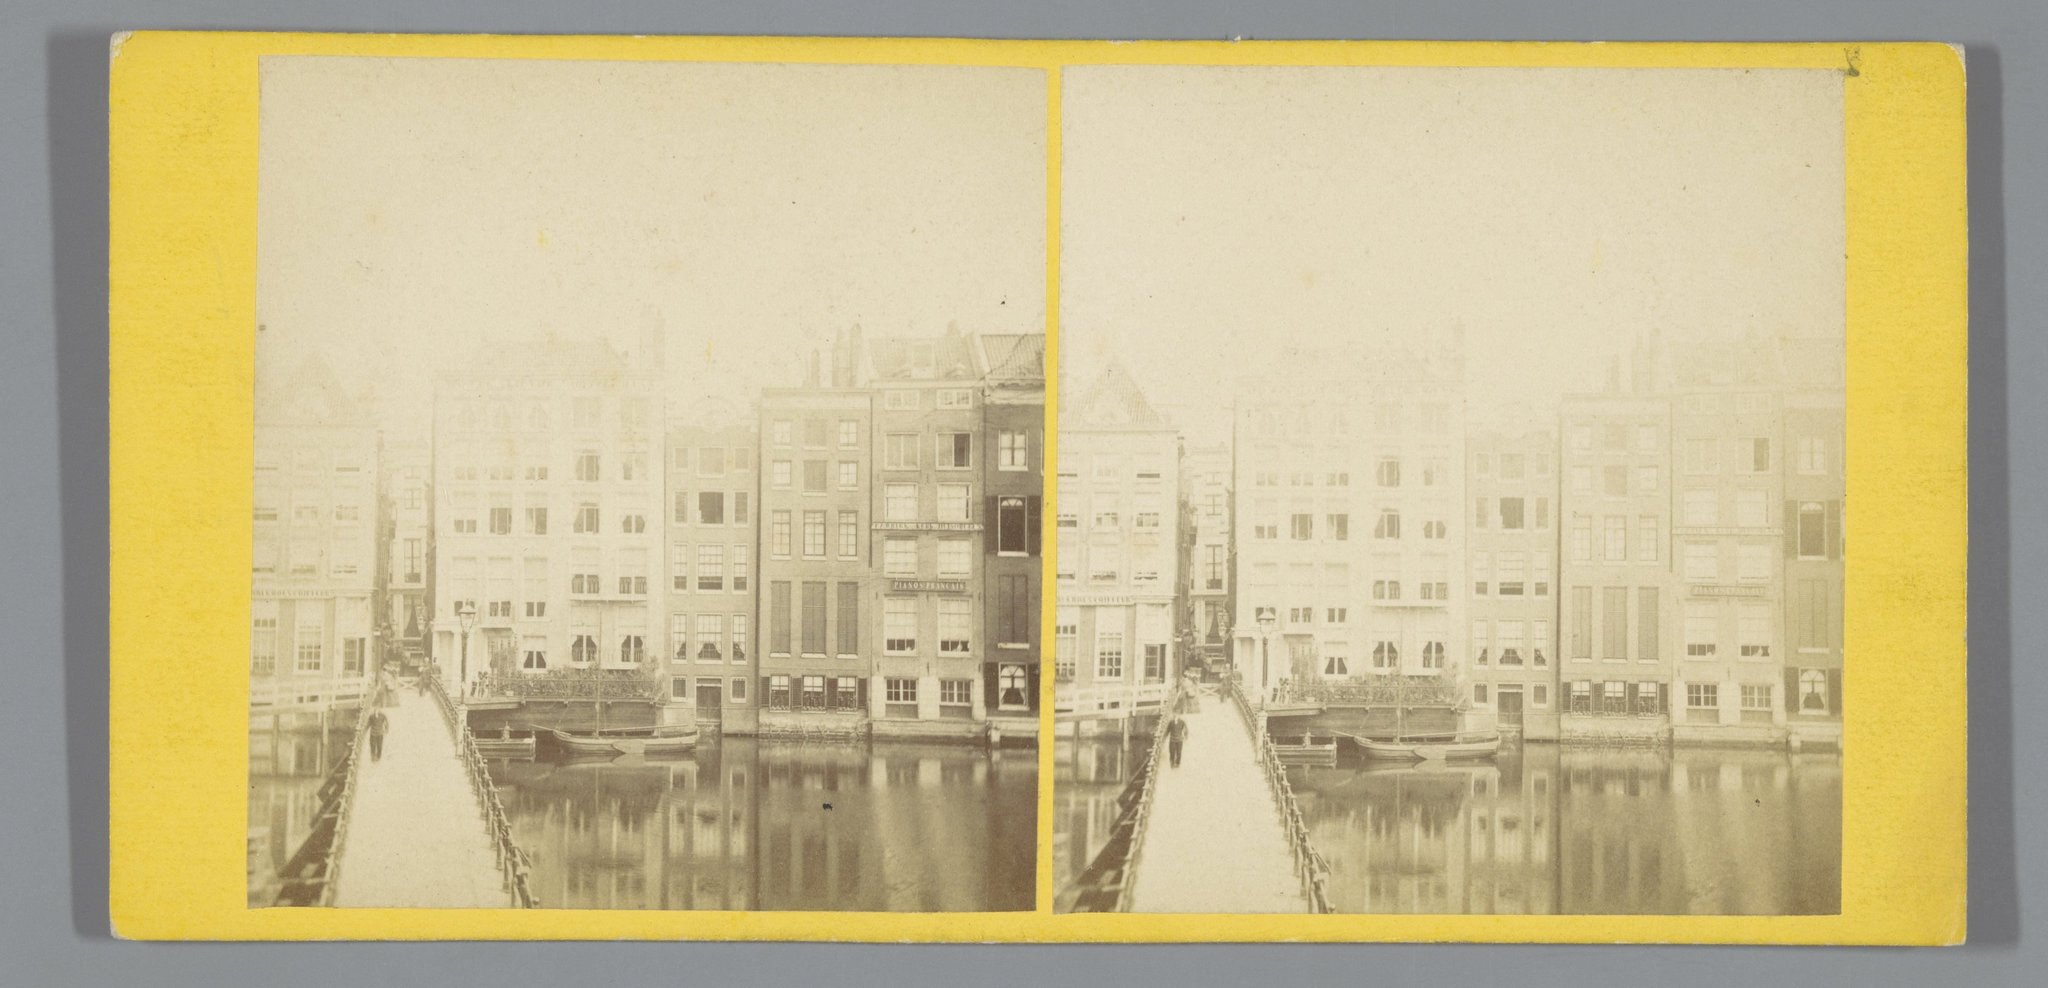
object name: stereograph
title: Gezicht op logement Het Haasje aan het Damrak in Amsterdam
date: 1860-1885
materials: cardboard, photographic support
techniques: albumen print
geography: amsterdam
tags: bridge, hotel, hostelry, inn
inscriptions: number: ‘2’, inscription: ‘Het Logement: het Haasje.’, annotation: ‘Amsterdam./ Damrak met Papenbrug en Papenbrugsteeg/ (Papenbrug gesloopt 1883)’